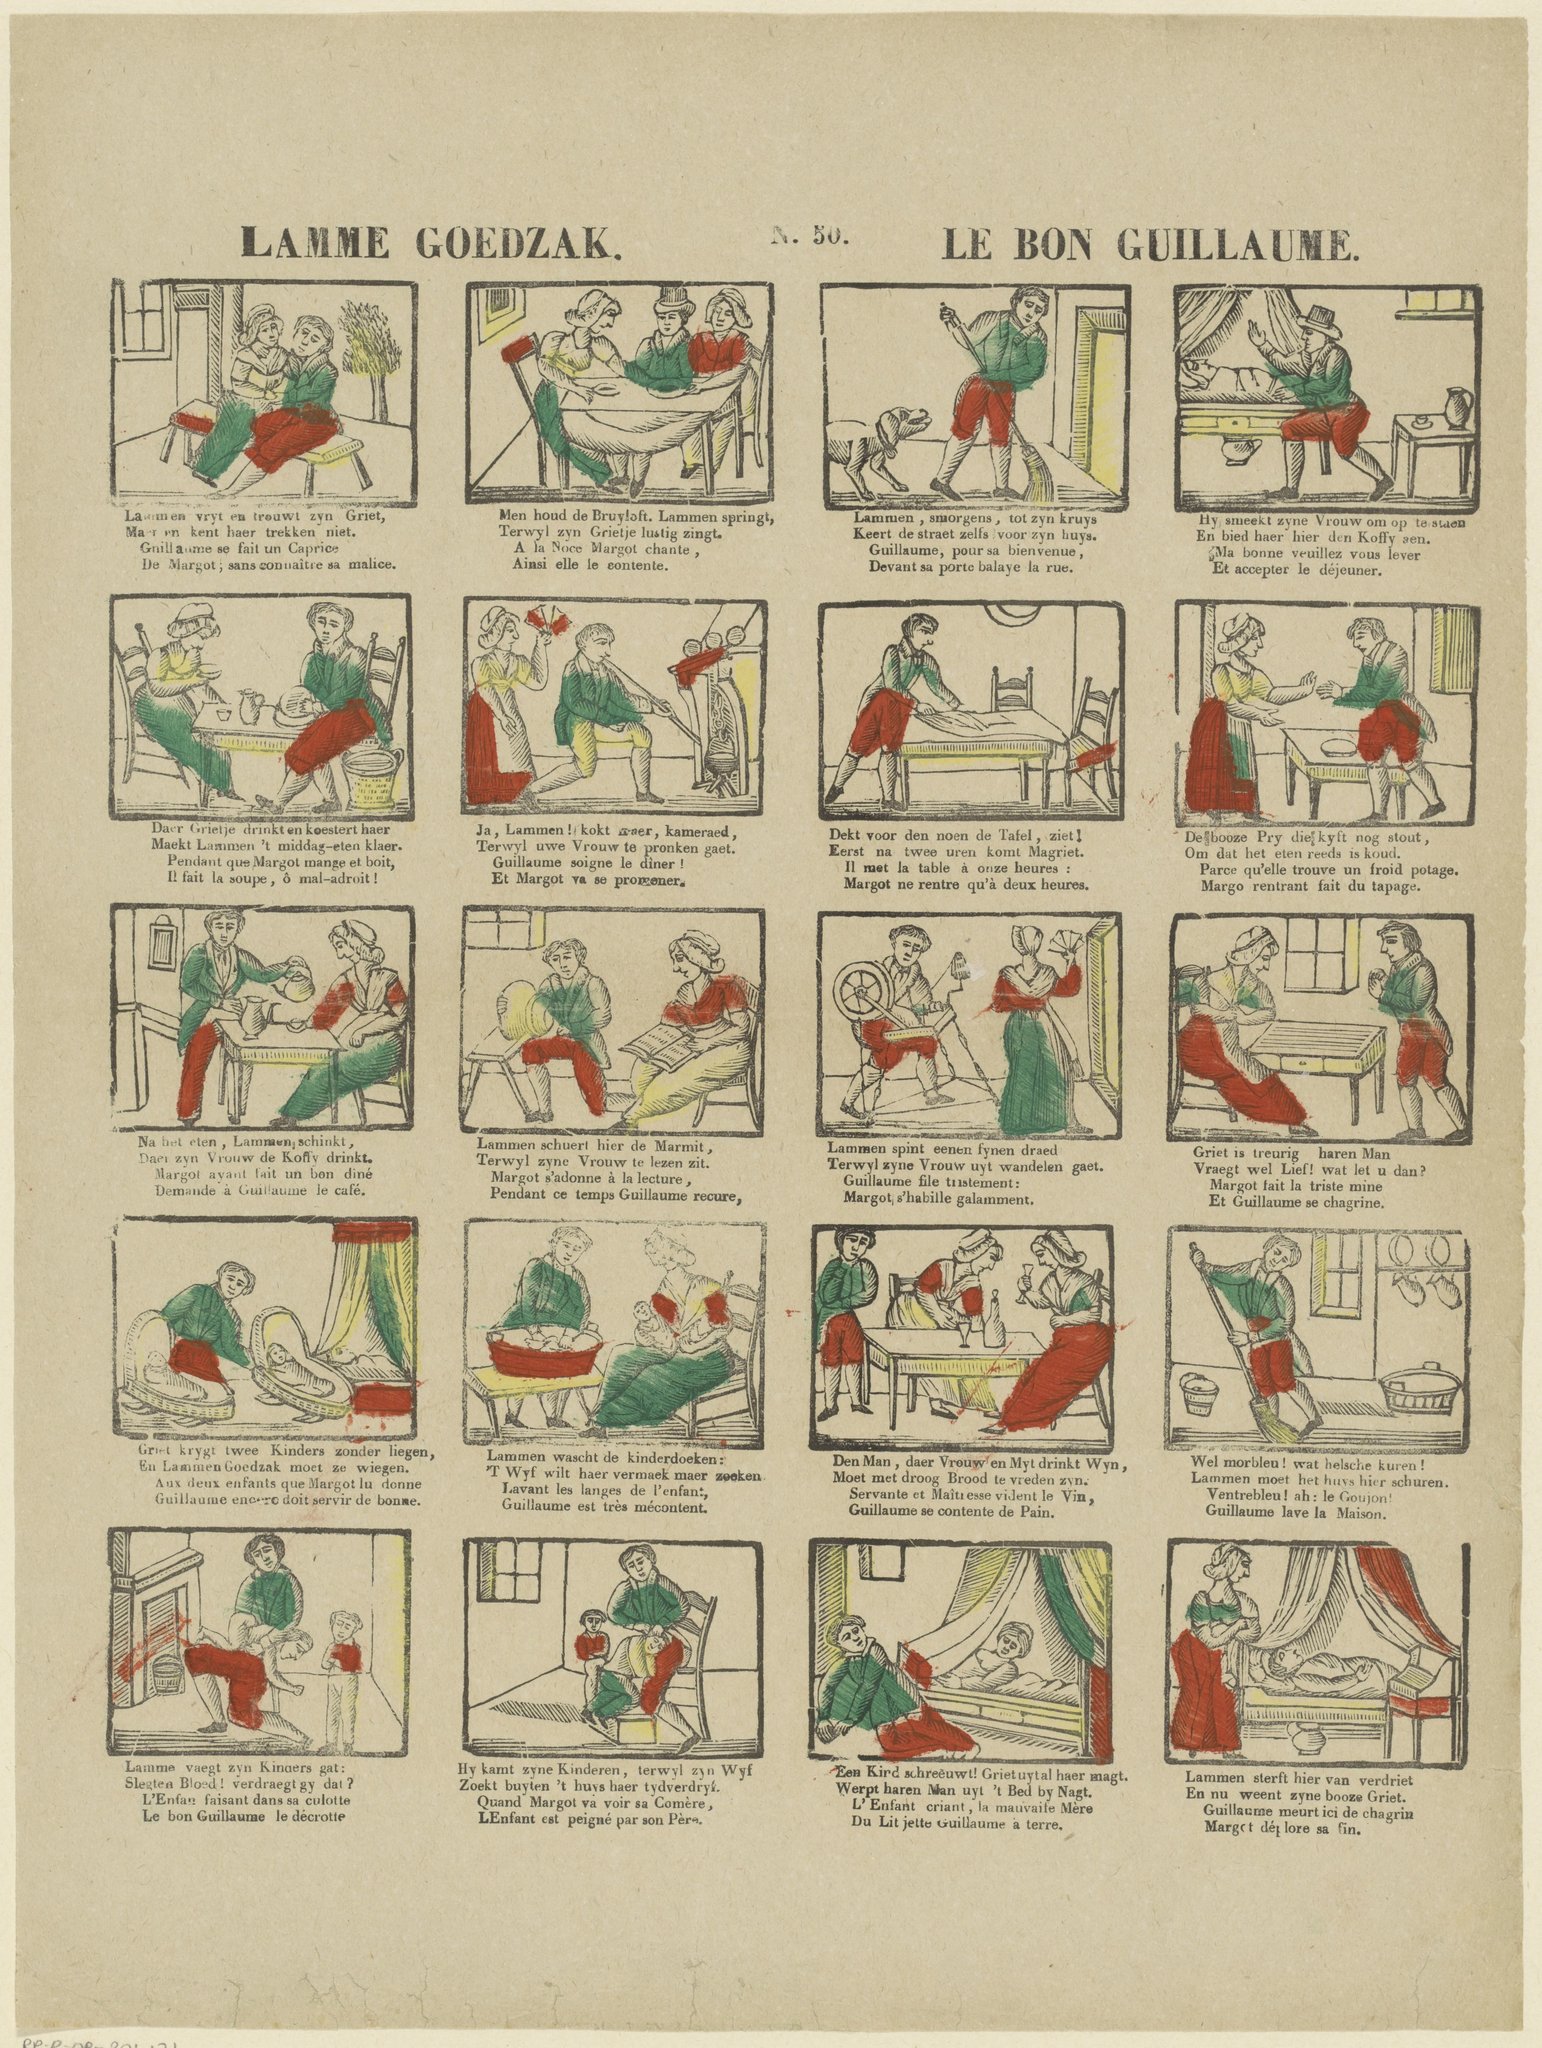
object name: popular print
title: Lamme goedzak / Le bon Guillaume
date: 1866-1902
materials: paper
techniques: colour, letterpress printing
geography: europe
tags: hen-pecked husband, 'betty', 'molly' (man who engages in women's work)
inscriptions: collector's mark: Lugt 2760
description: Blad met 20 voorstellingen over het leven en de bezigheden van Lamme Goedzak en zijn Griet. Onder elke voorstelling een tweeregelig vers in het Nederlands en het Frans. Genummerd midden boven: N. 50.